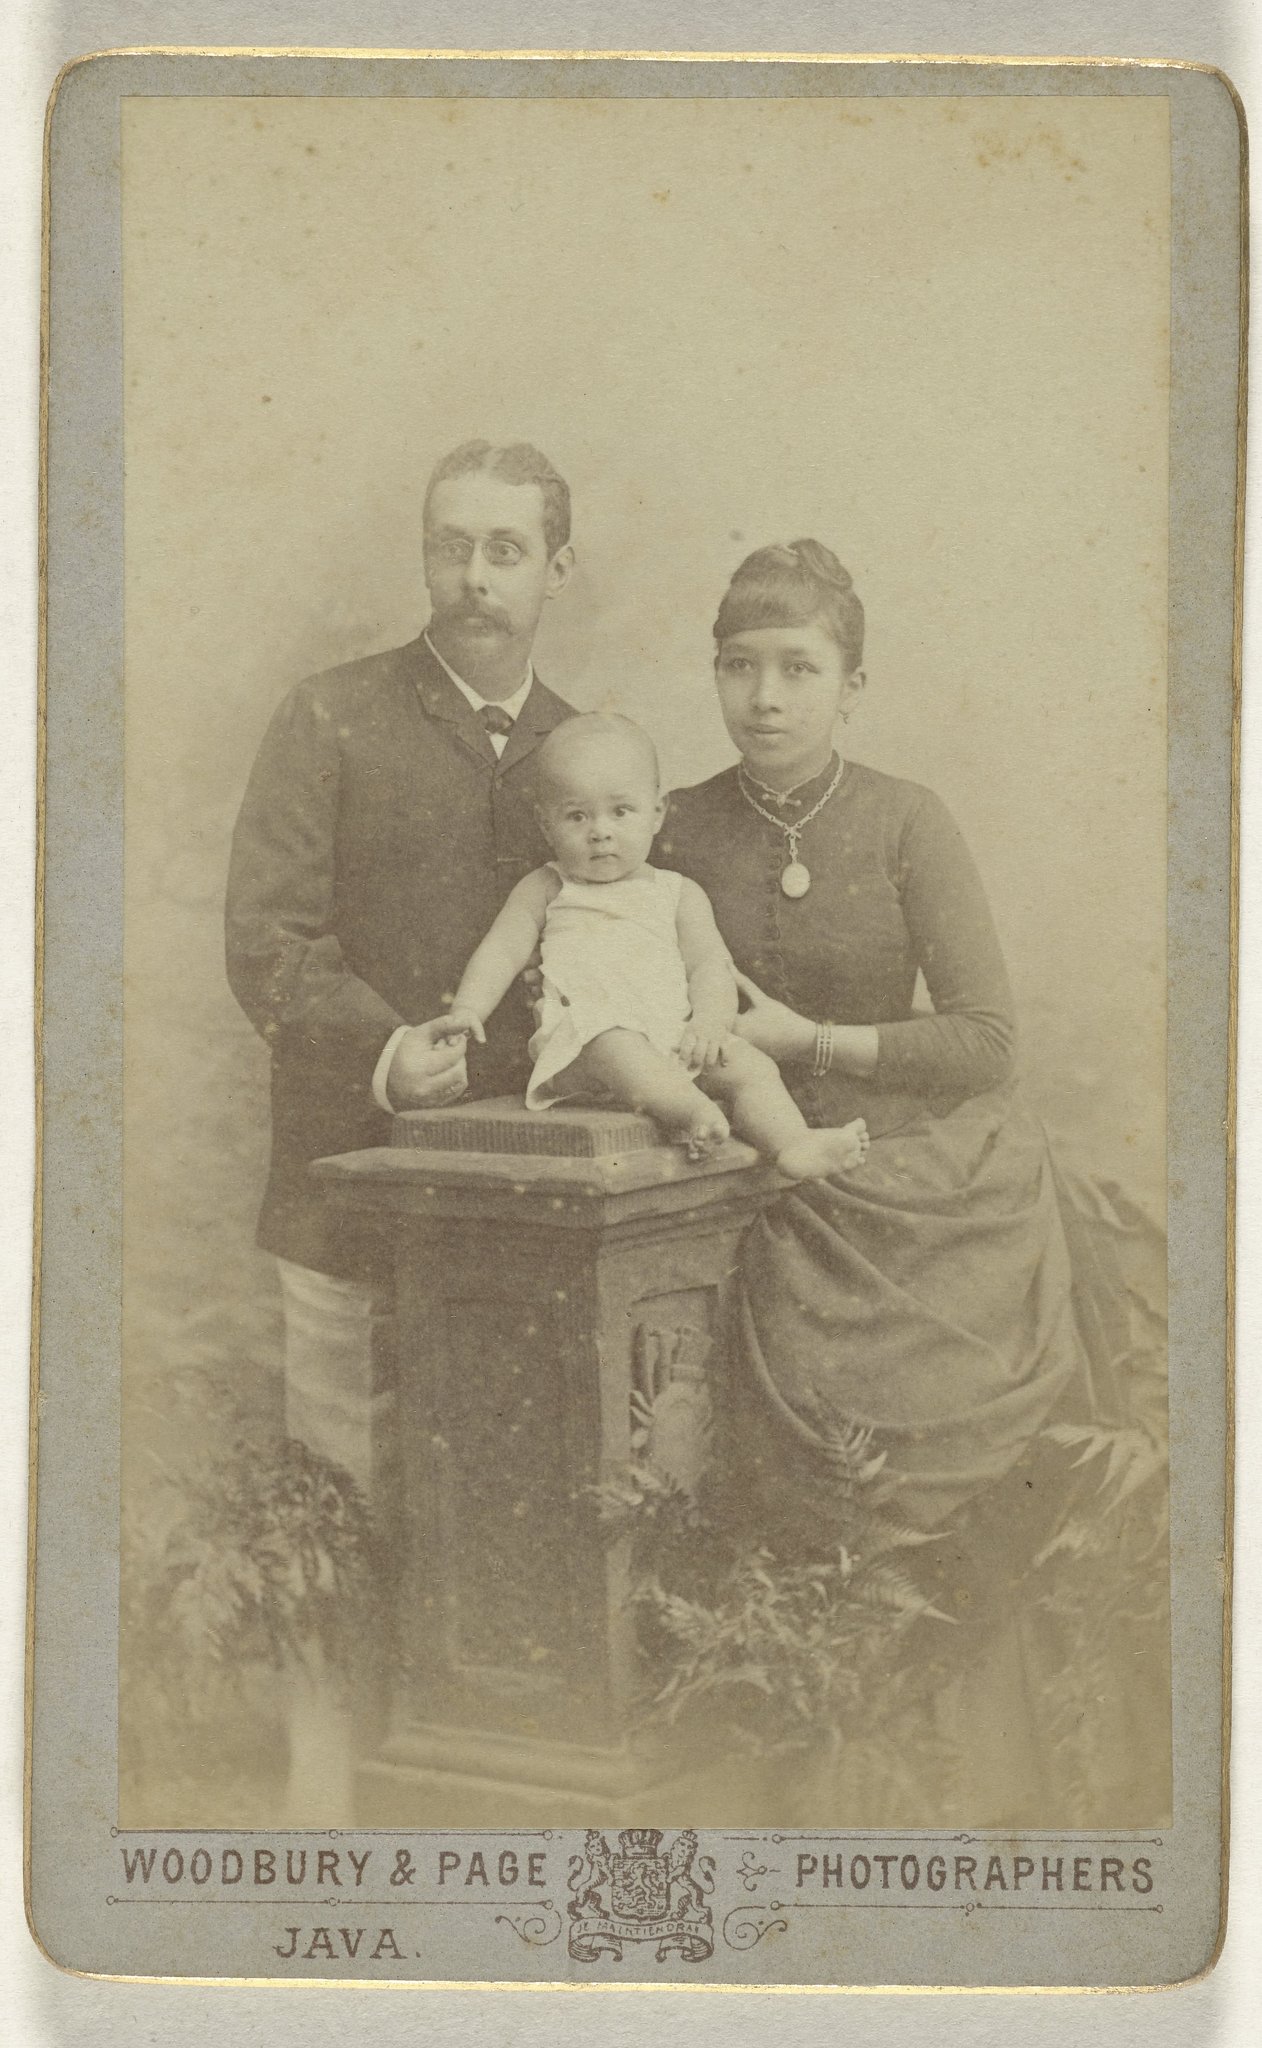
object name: photograph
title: Studioportret van een een gezin bestaande uit een Nederlandse man, een Javaanse vrouw en een baby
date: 1890-1915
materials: paper, photographic support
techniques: photography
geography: java